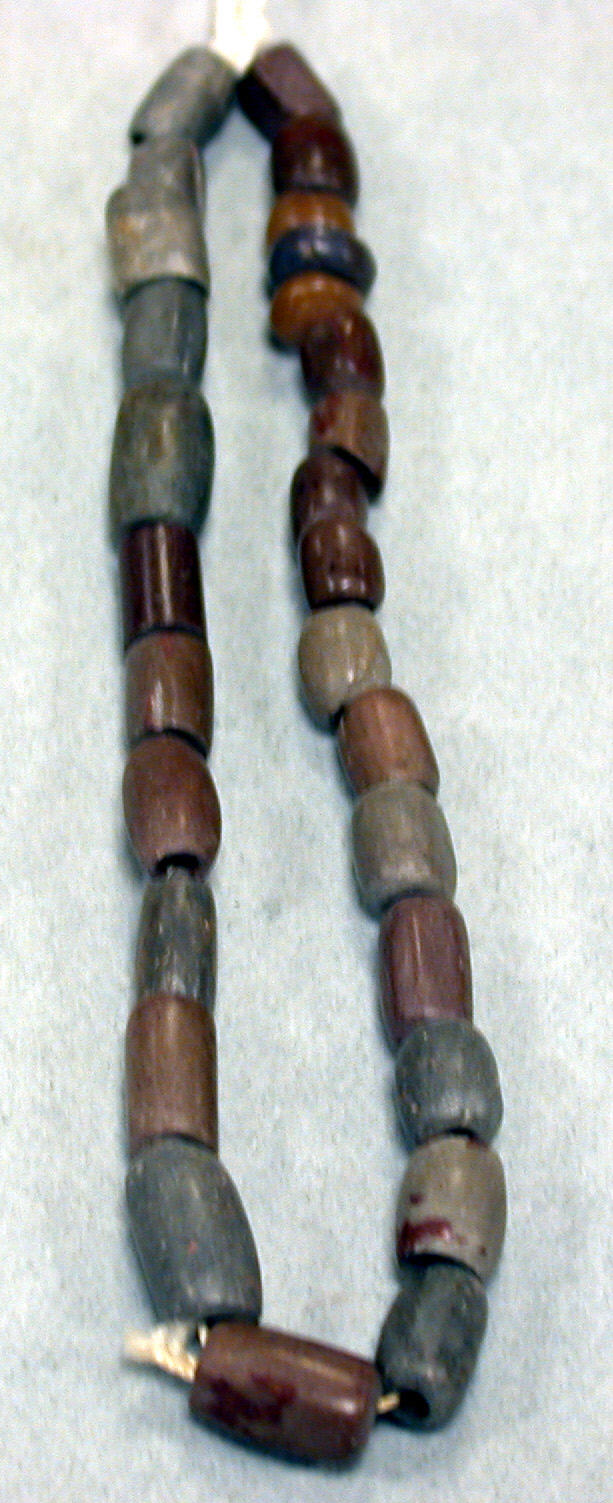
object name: bead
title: Necklace of Stone Beads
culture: peruvian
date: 1-1566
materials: stone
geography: peru